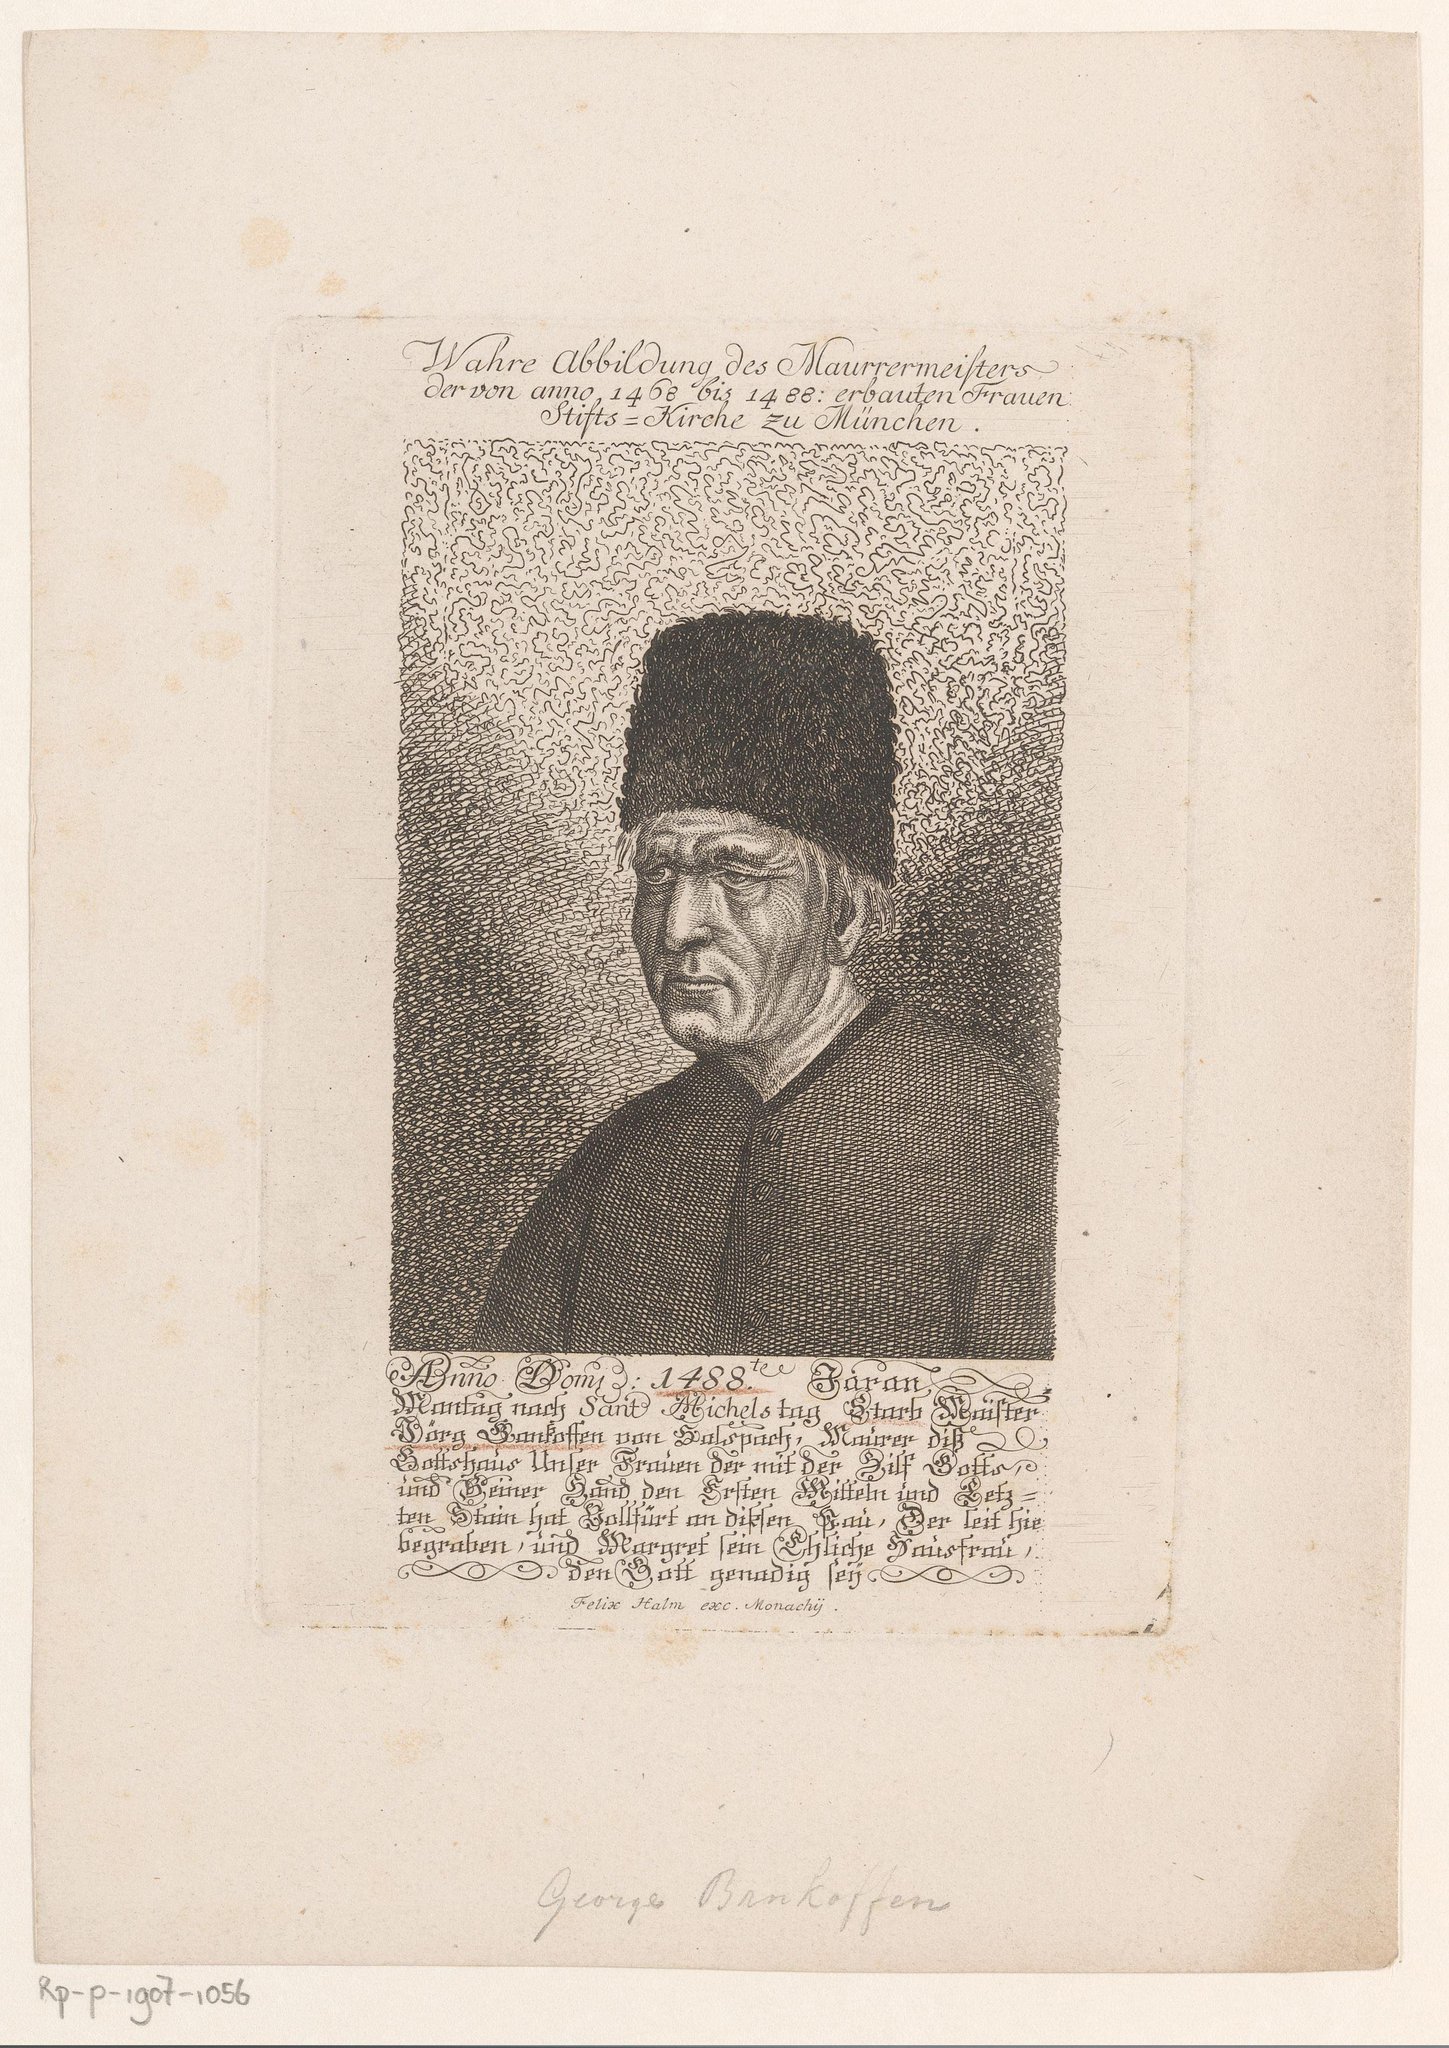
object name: print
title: Portret van Jörg von Halsbach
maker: felix halm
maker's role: painter, print maker, publisher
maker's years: 1758-1810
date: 1768-1810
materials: paper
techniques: etching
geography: munich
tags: historical persons, portrait, self-portrait of architect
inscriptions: collector's mark: Lugt 2228